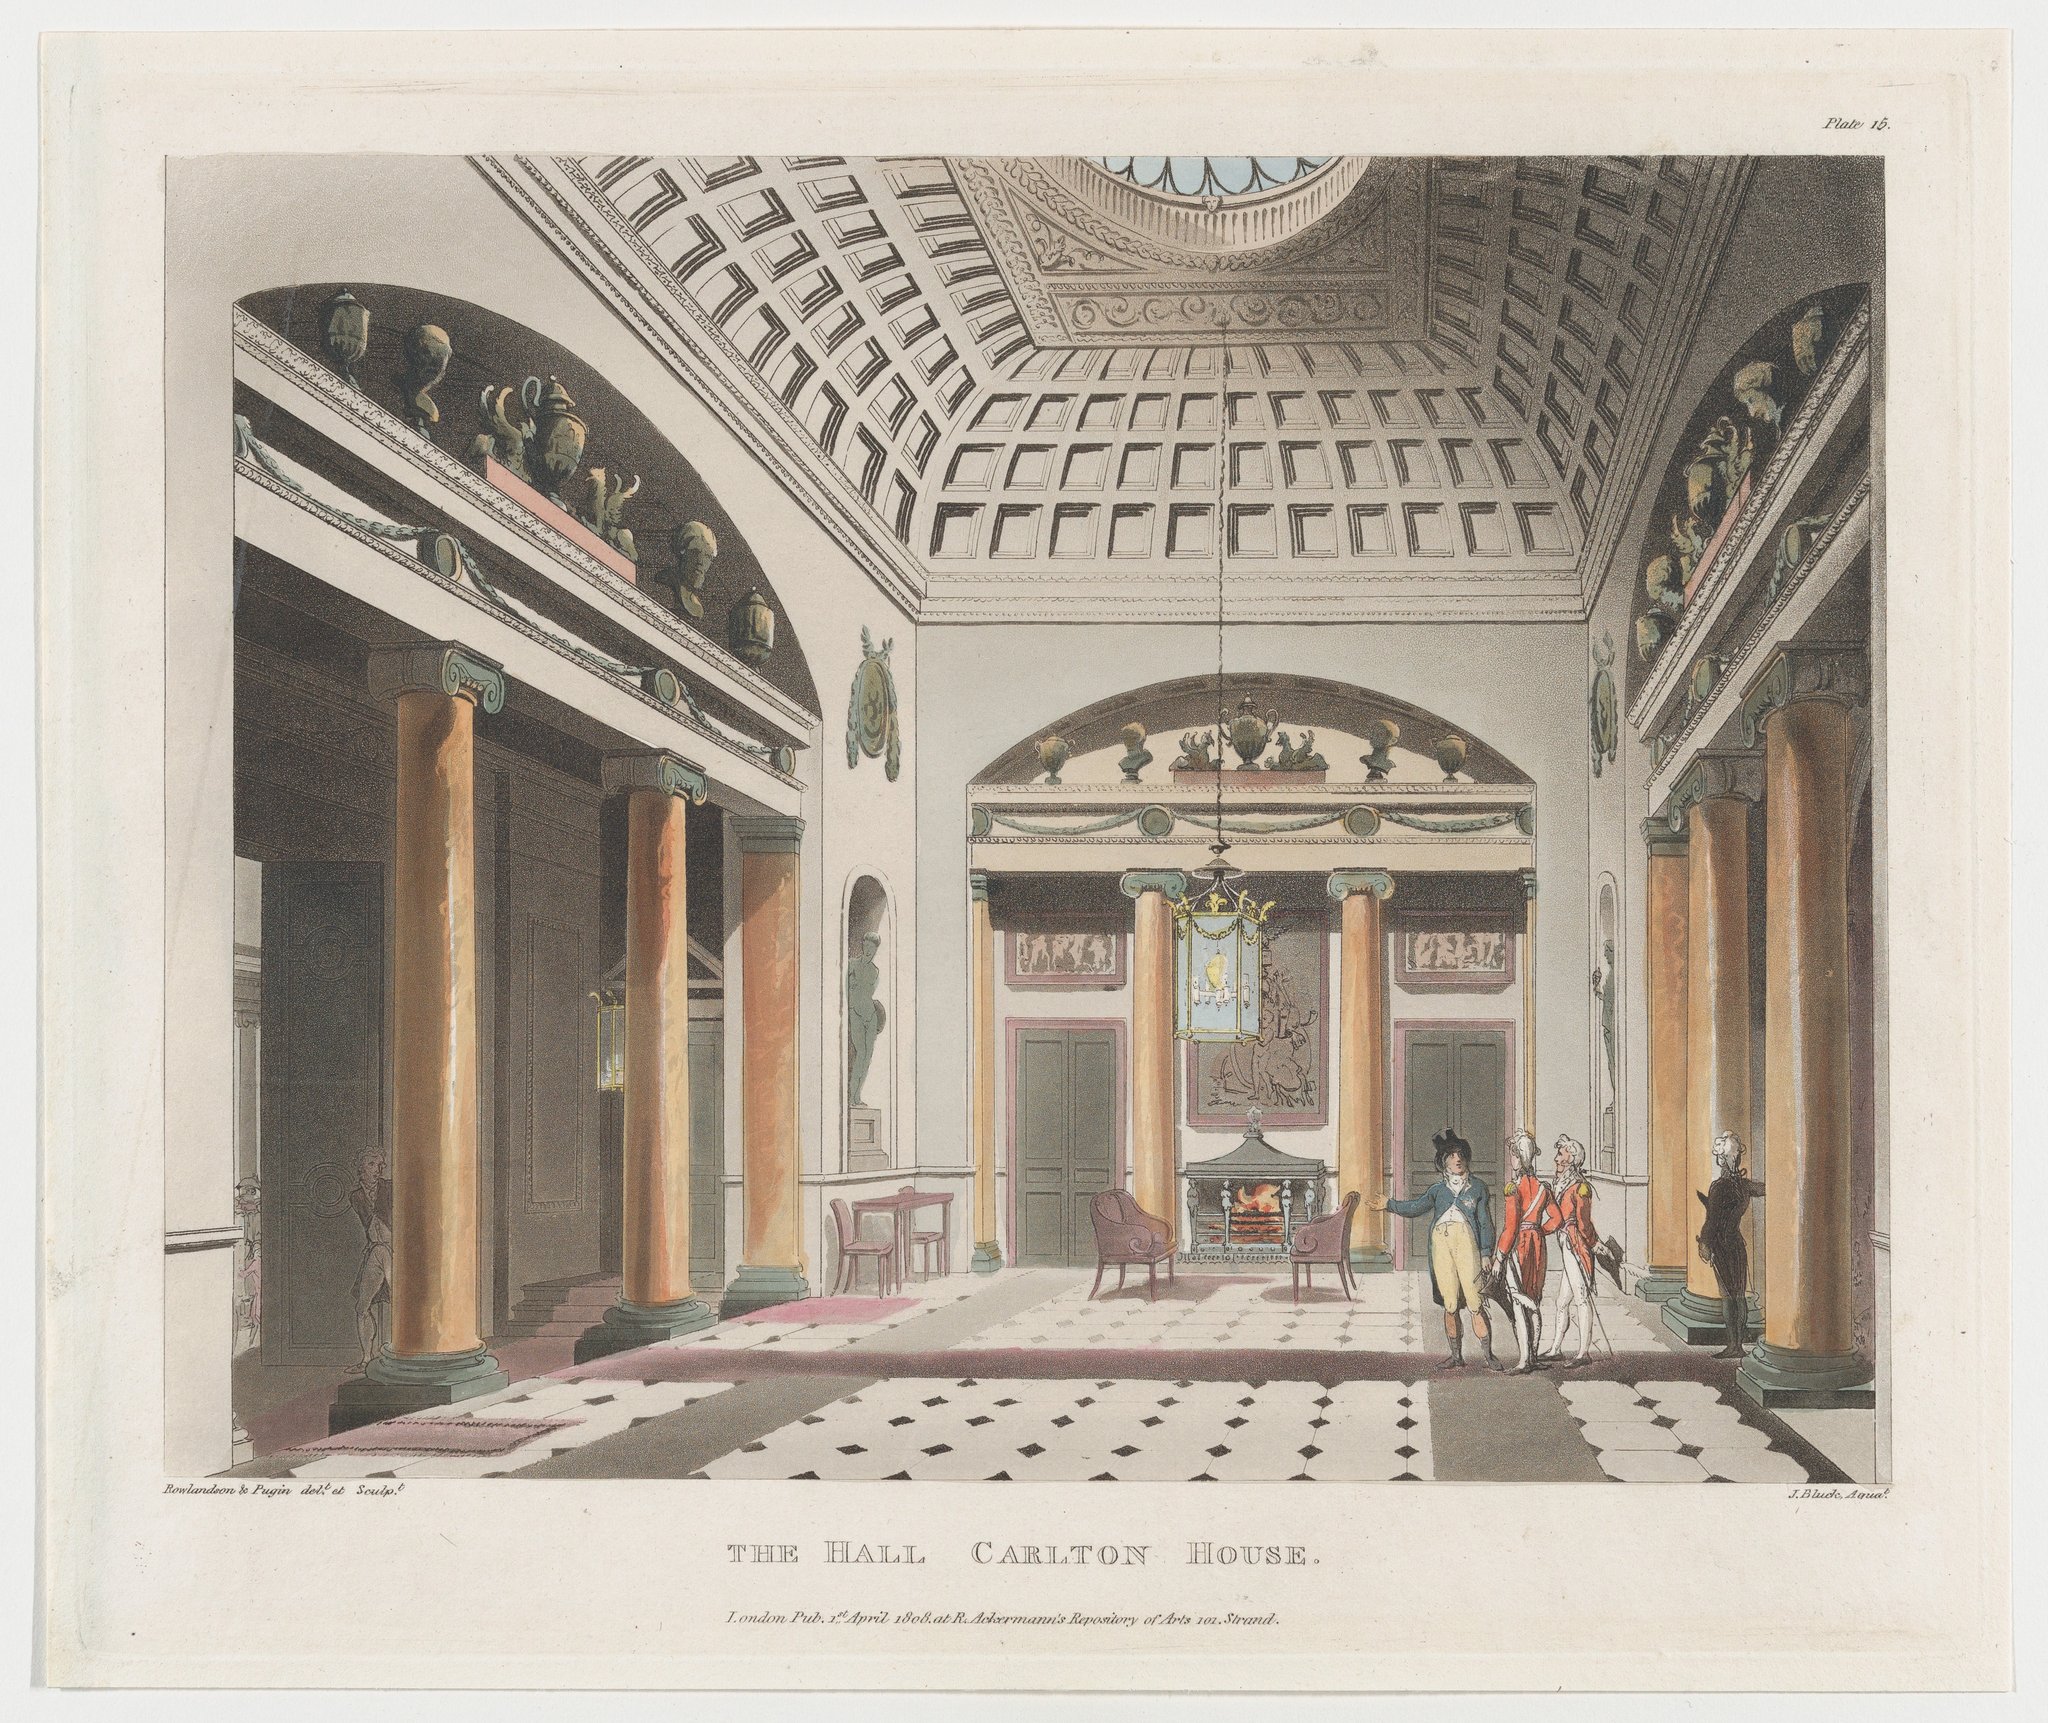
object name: print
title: The Hall Carlton House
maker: thomas rowlandson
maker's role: artist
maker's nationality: british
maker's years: 1757-1827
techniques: aquatint, etching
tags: architecture,houses,interiors